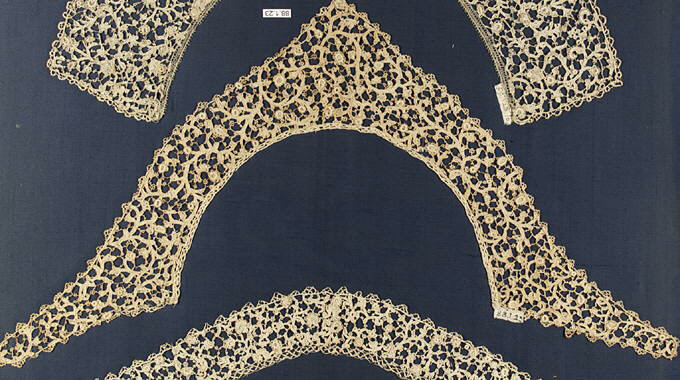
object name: collar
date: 1667-1733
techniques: lace